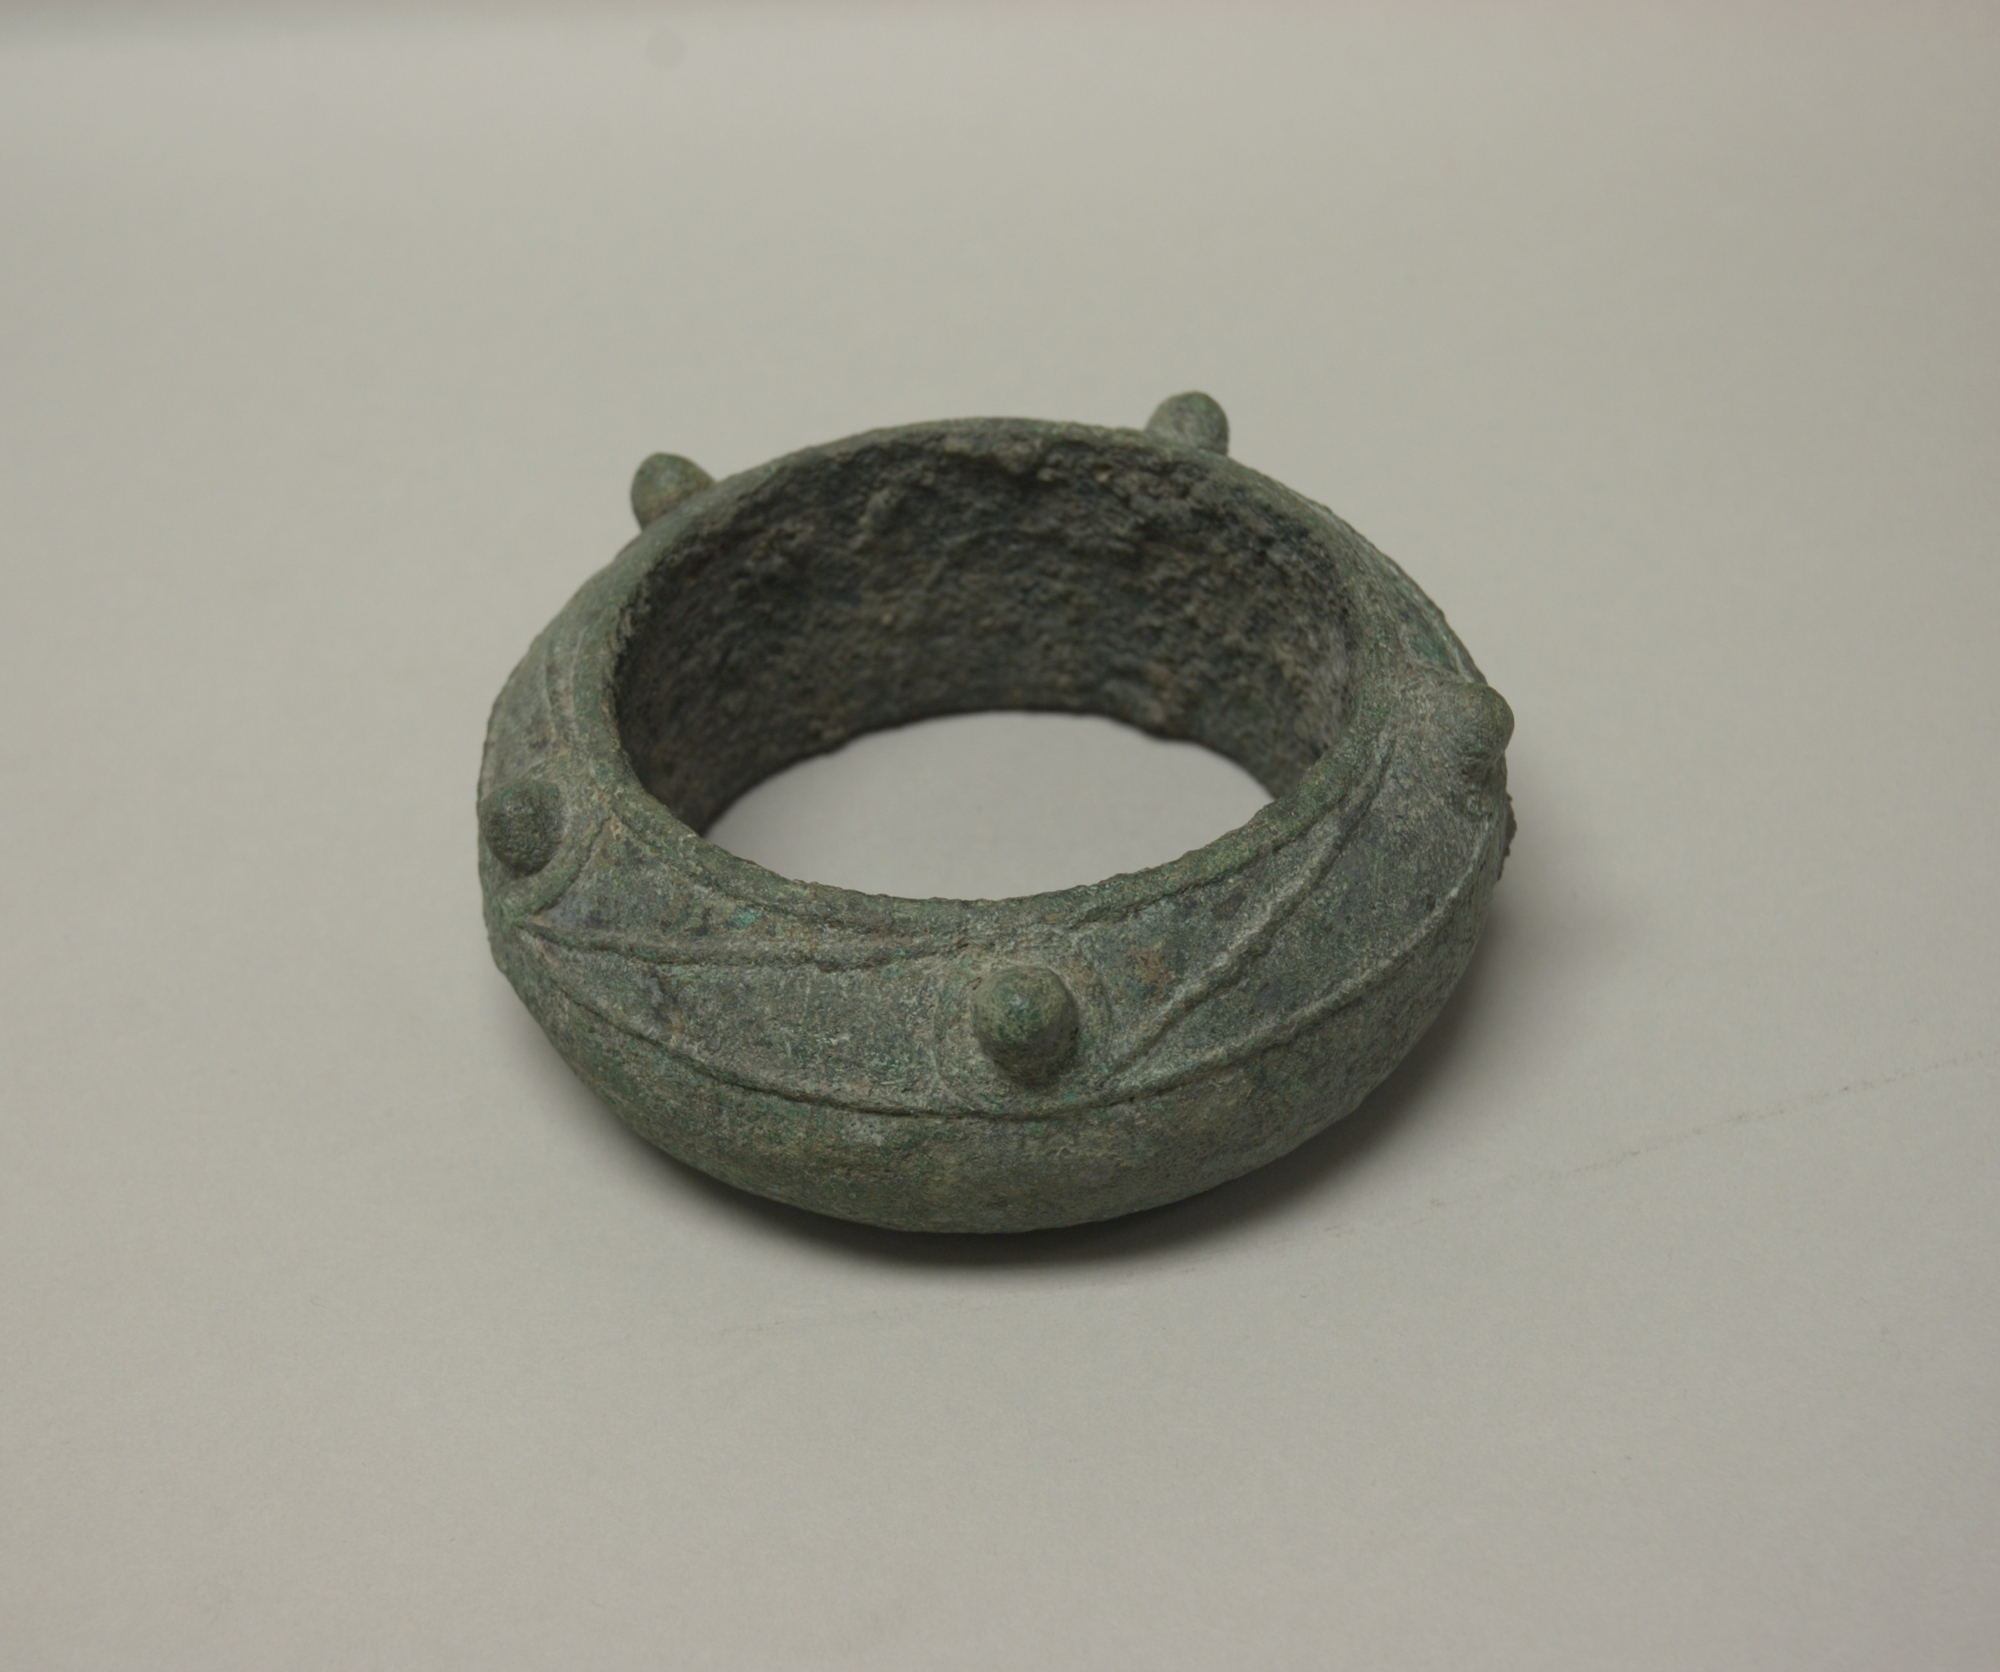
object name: bracelet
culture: vietnamese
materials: bronze